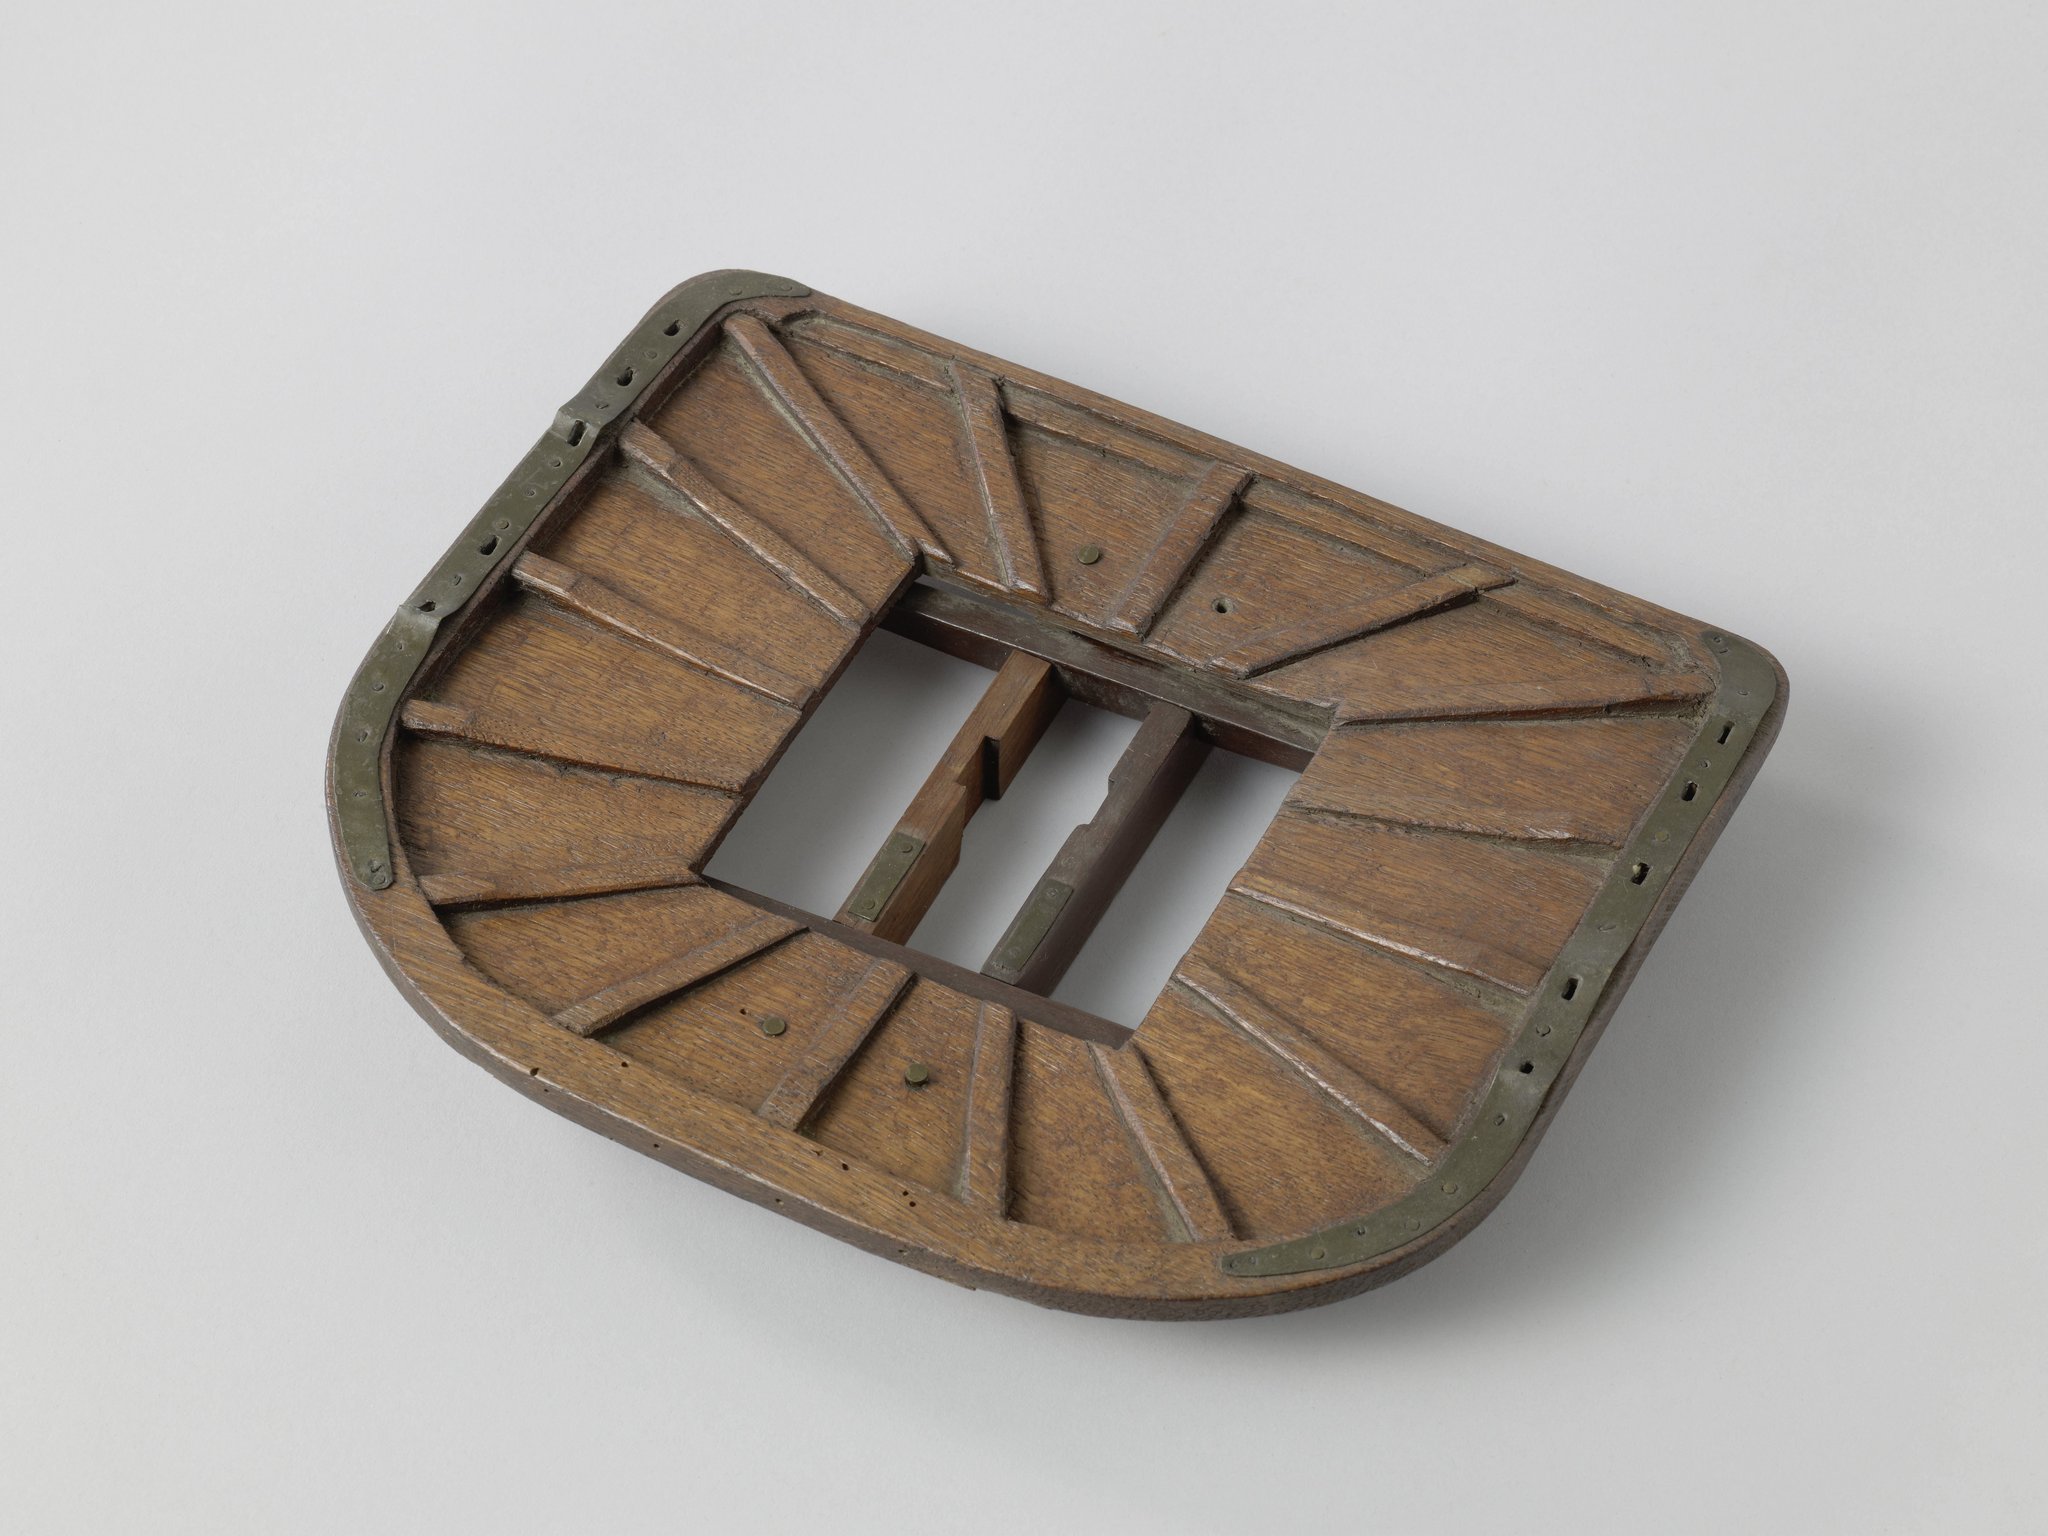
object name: demonstration model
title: Model of a Maintop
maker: Anonymous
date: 1780-1800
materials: brass, wood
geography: netherlands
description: Model van een grote mars, aan de voorkant afgerond, met twee langs- en twee dwarszalings onder. De marsrand is verstevigd met koper en de marsvloer is dicht en verstevigd met snaphanen, straalsgewijs rond het soldatengat.